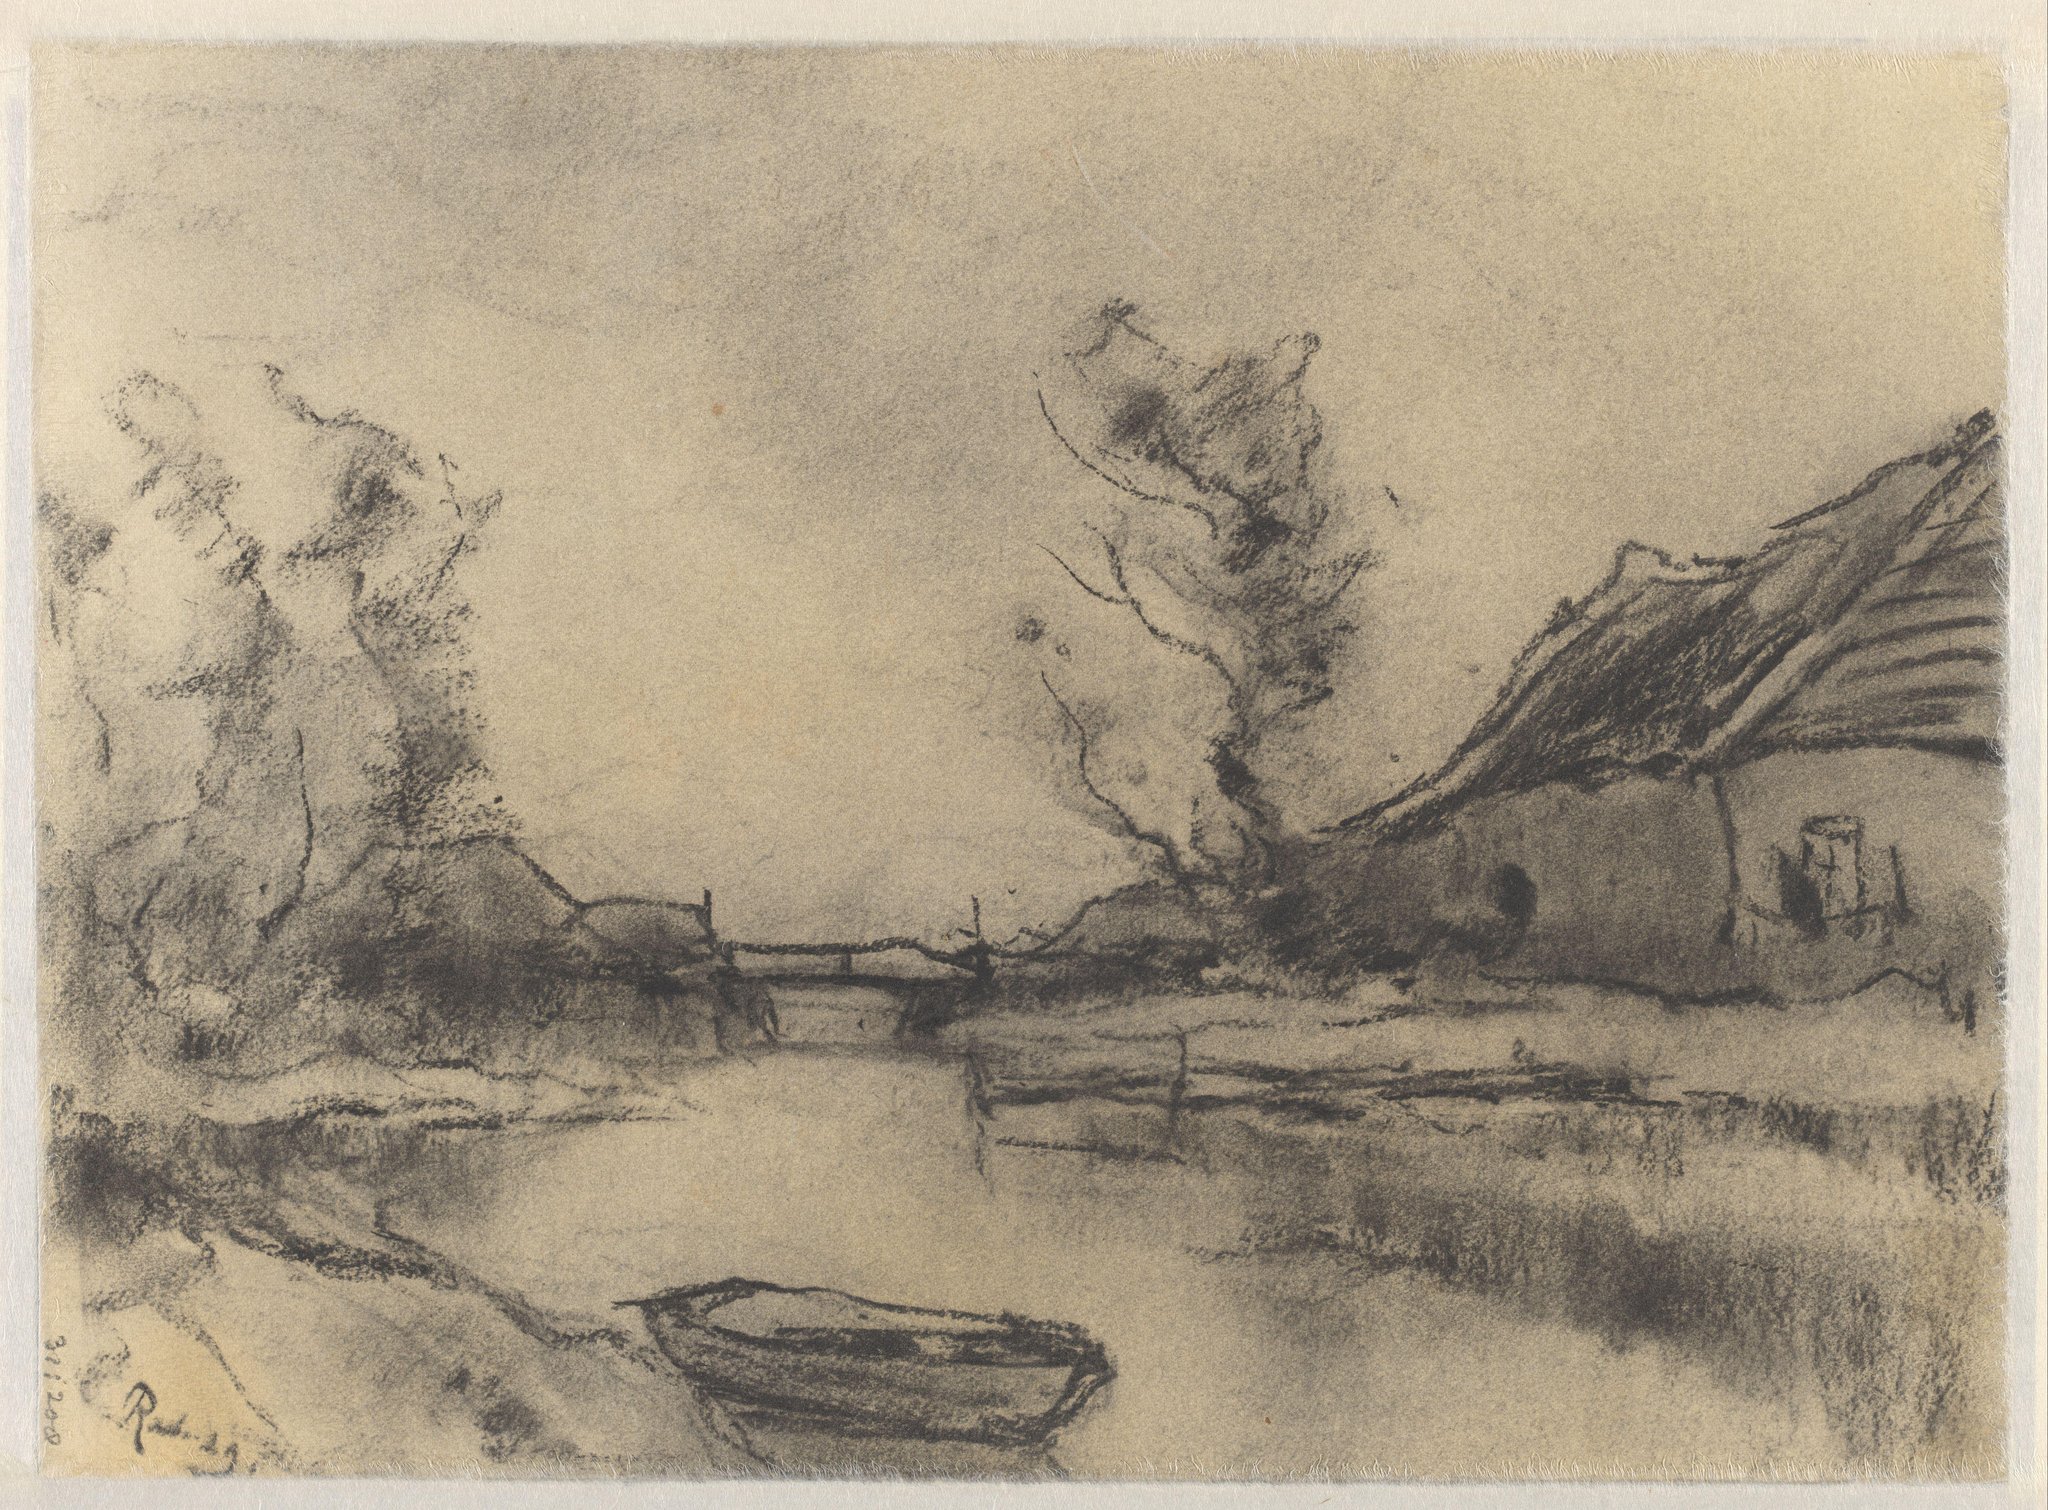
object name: drawing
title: Boerderijen aan een sloot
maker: pieter h.j.j. ras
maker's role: draughtsman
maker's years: 1857-1941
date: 1929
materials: chalk, paper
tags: farm (building)